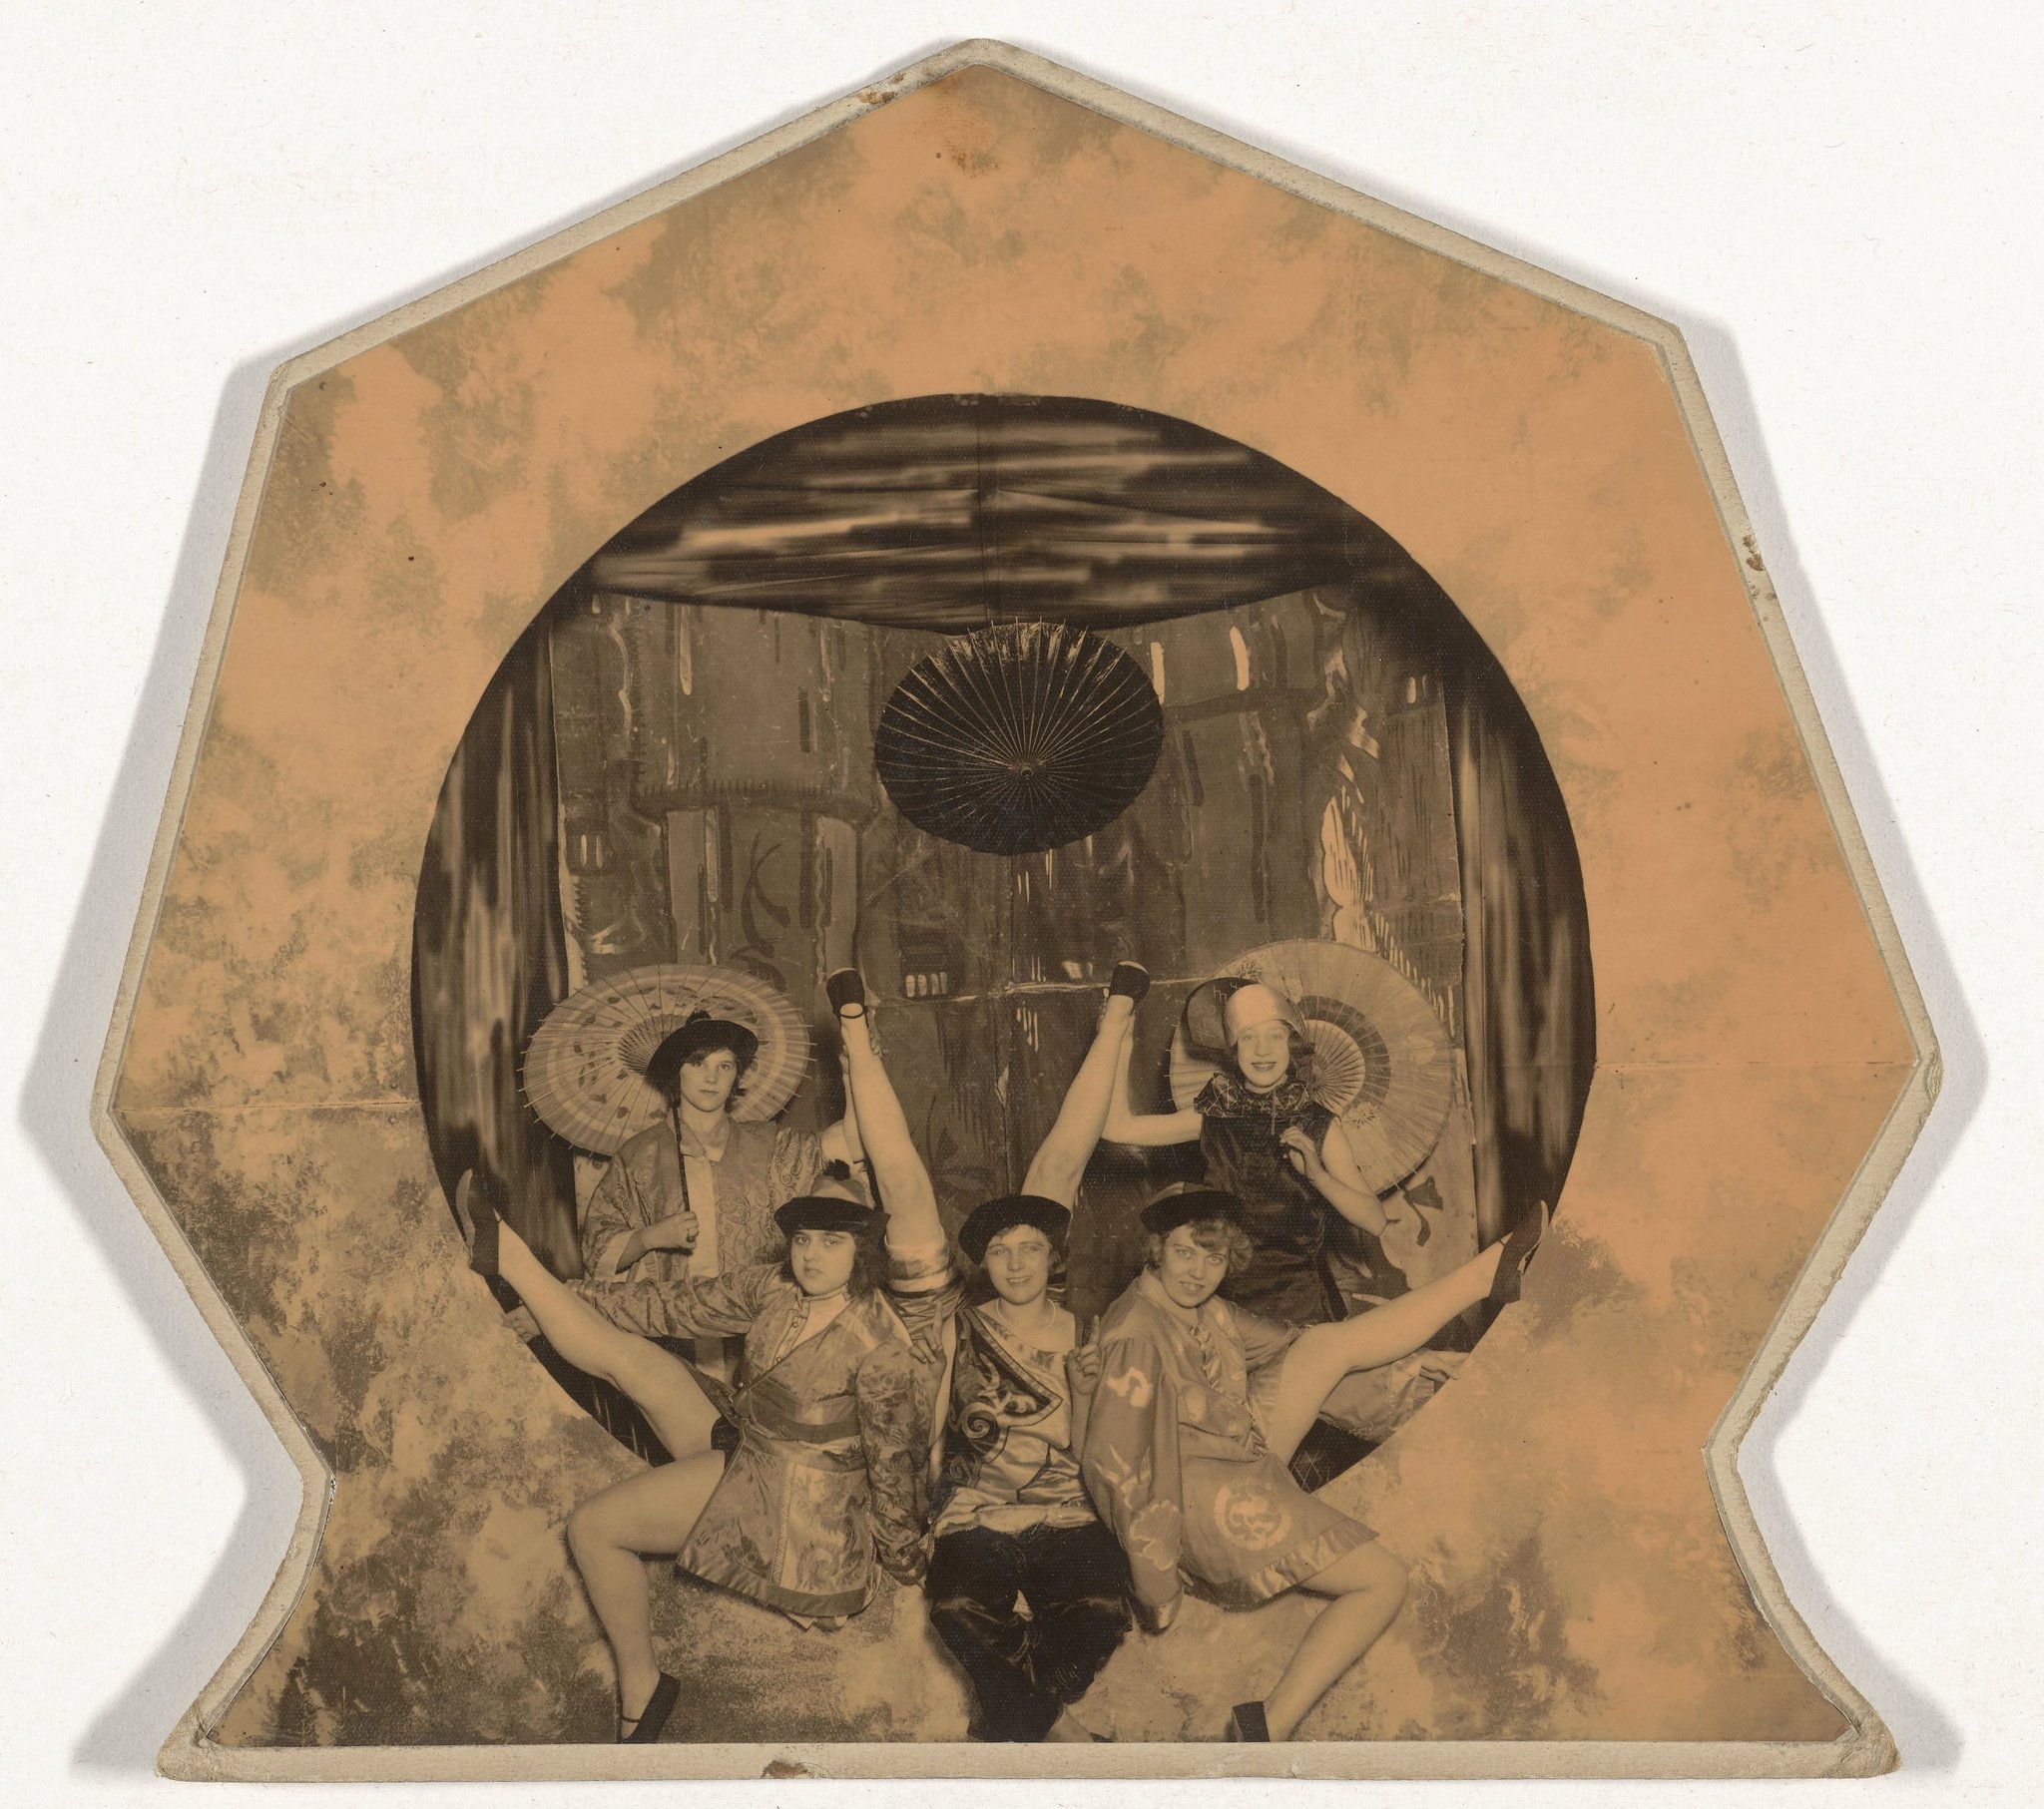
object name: photograph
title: Theatergroepsportret van zes onbekende vrouwen in Aziatische kostuums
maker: Anonymous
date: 1920-1930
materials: paper, cardboard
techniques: gelatin silver print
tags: portrait of actor, actress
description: De vrouwen zitten op en in een cirkelvormige uitsparing met ontblote benen.